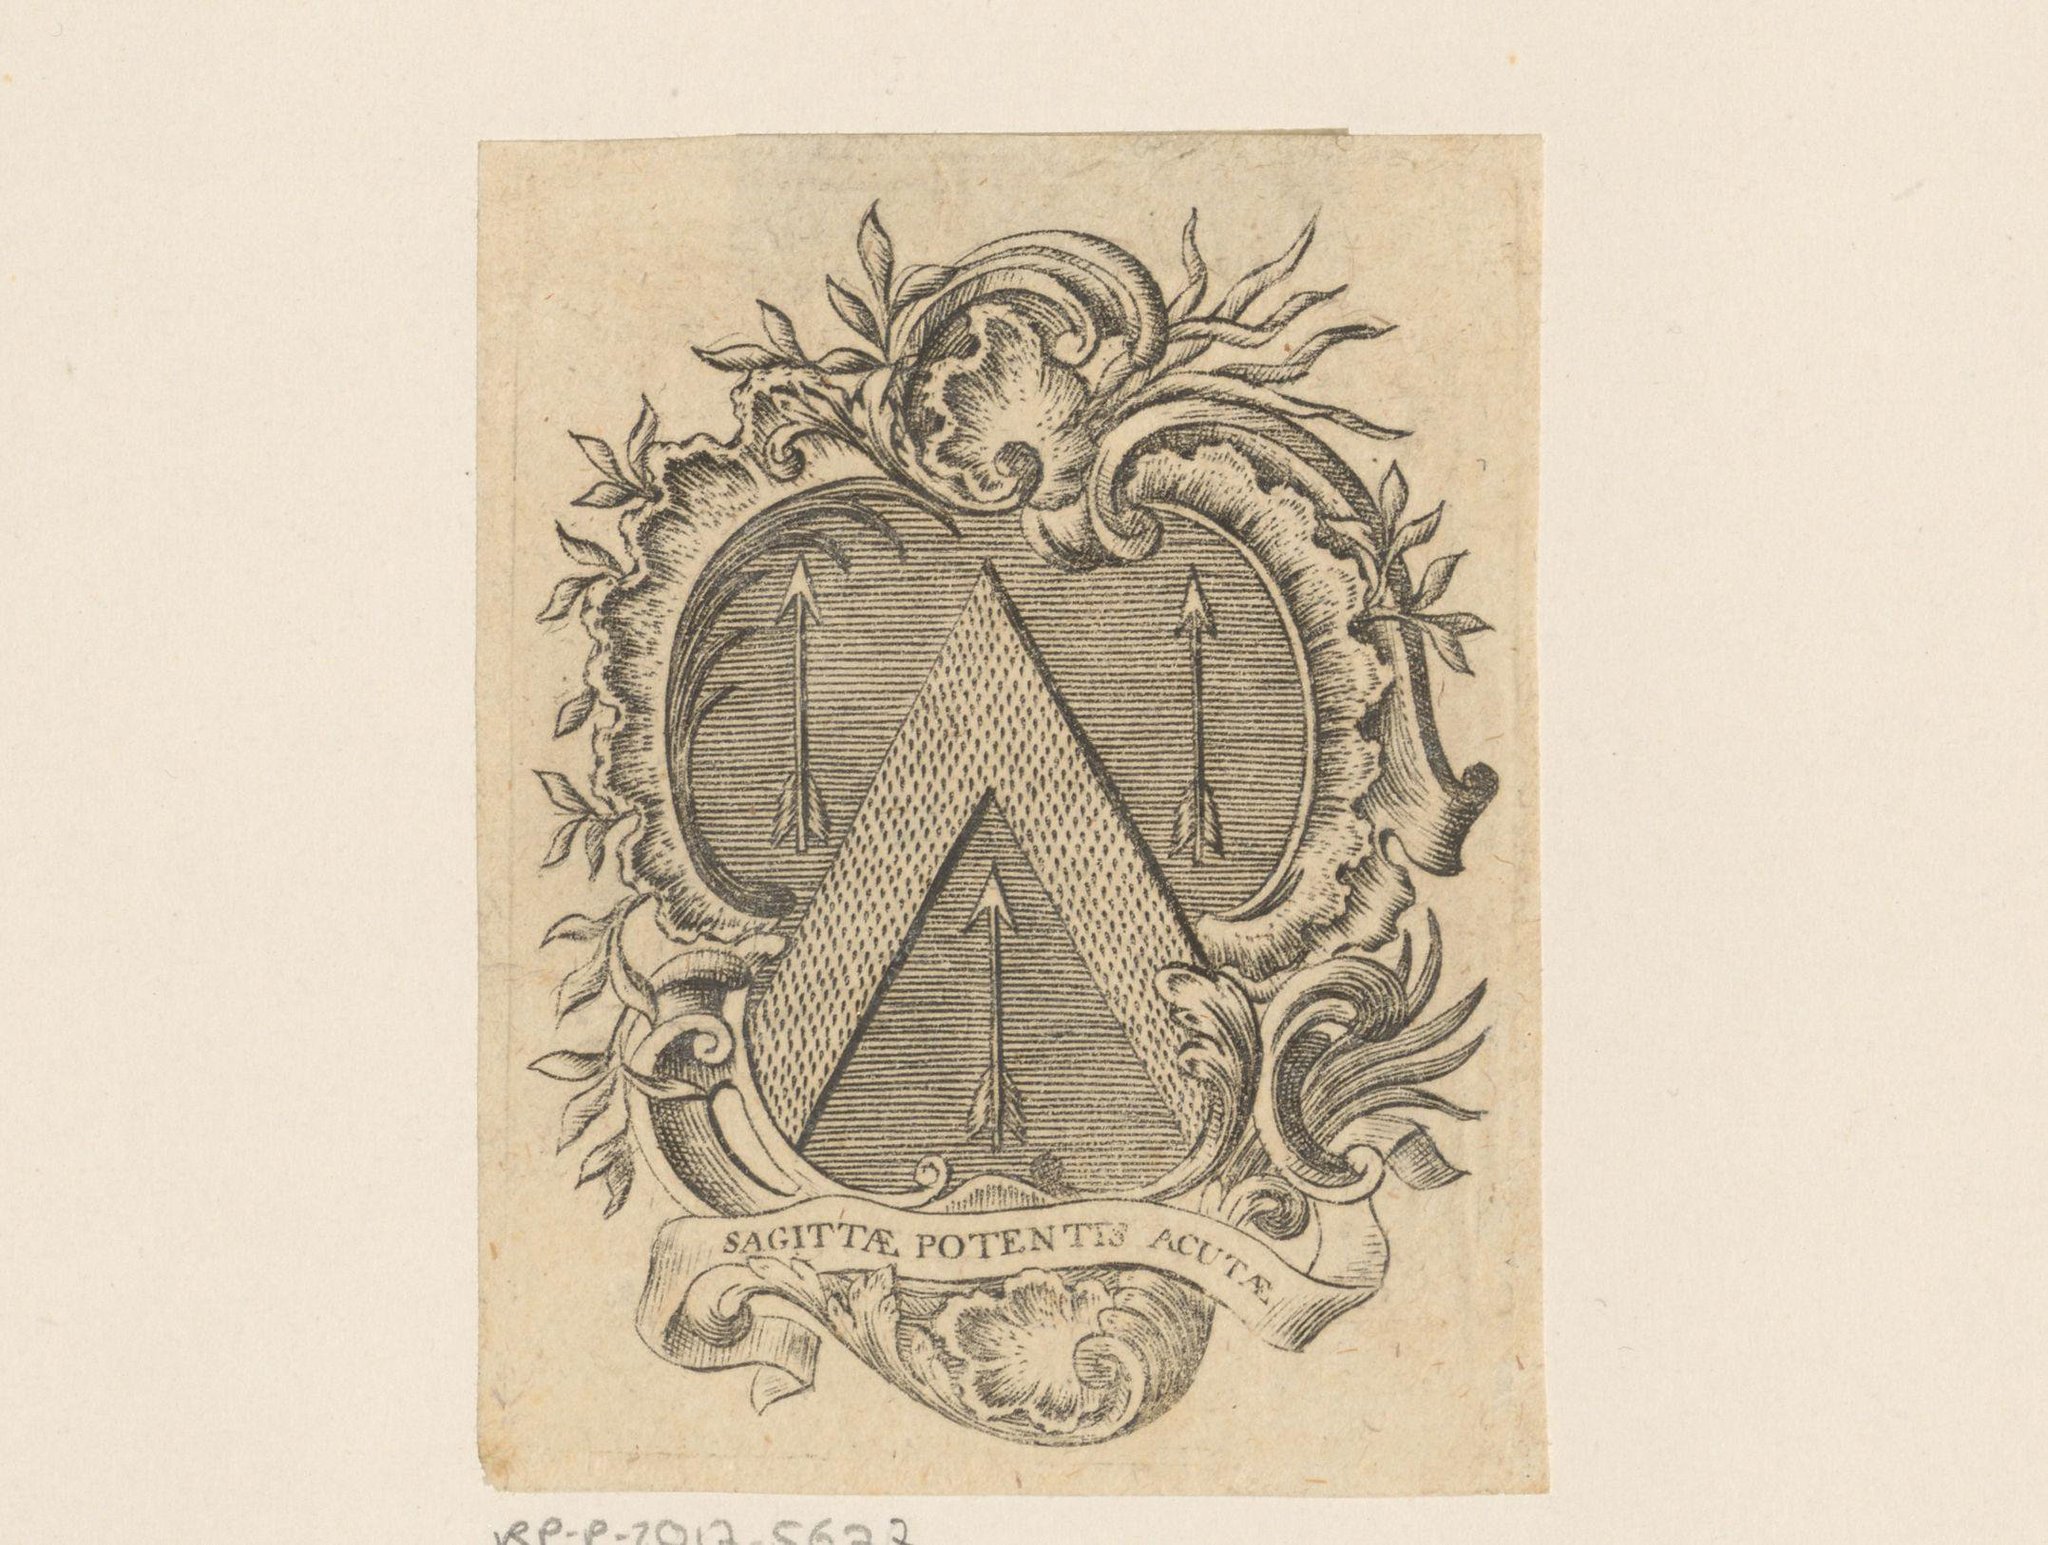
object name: bookplate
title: Sagittae potentis acutae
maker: Anonymous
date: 1700-1799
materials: paper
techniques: etching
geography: france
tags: rocaille ornament, archer's weapons: arrow, armorial bearing, heraldry